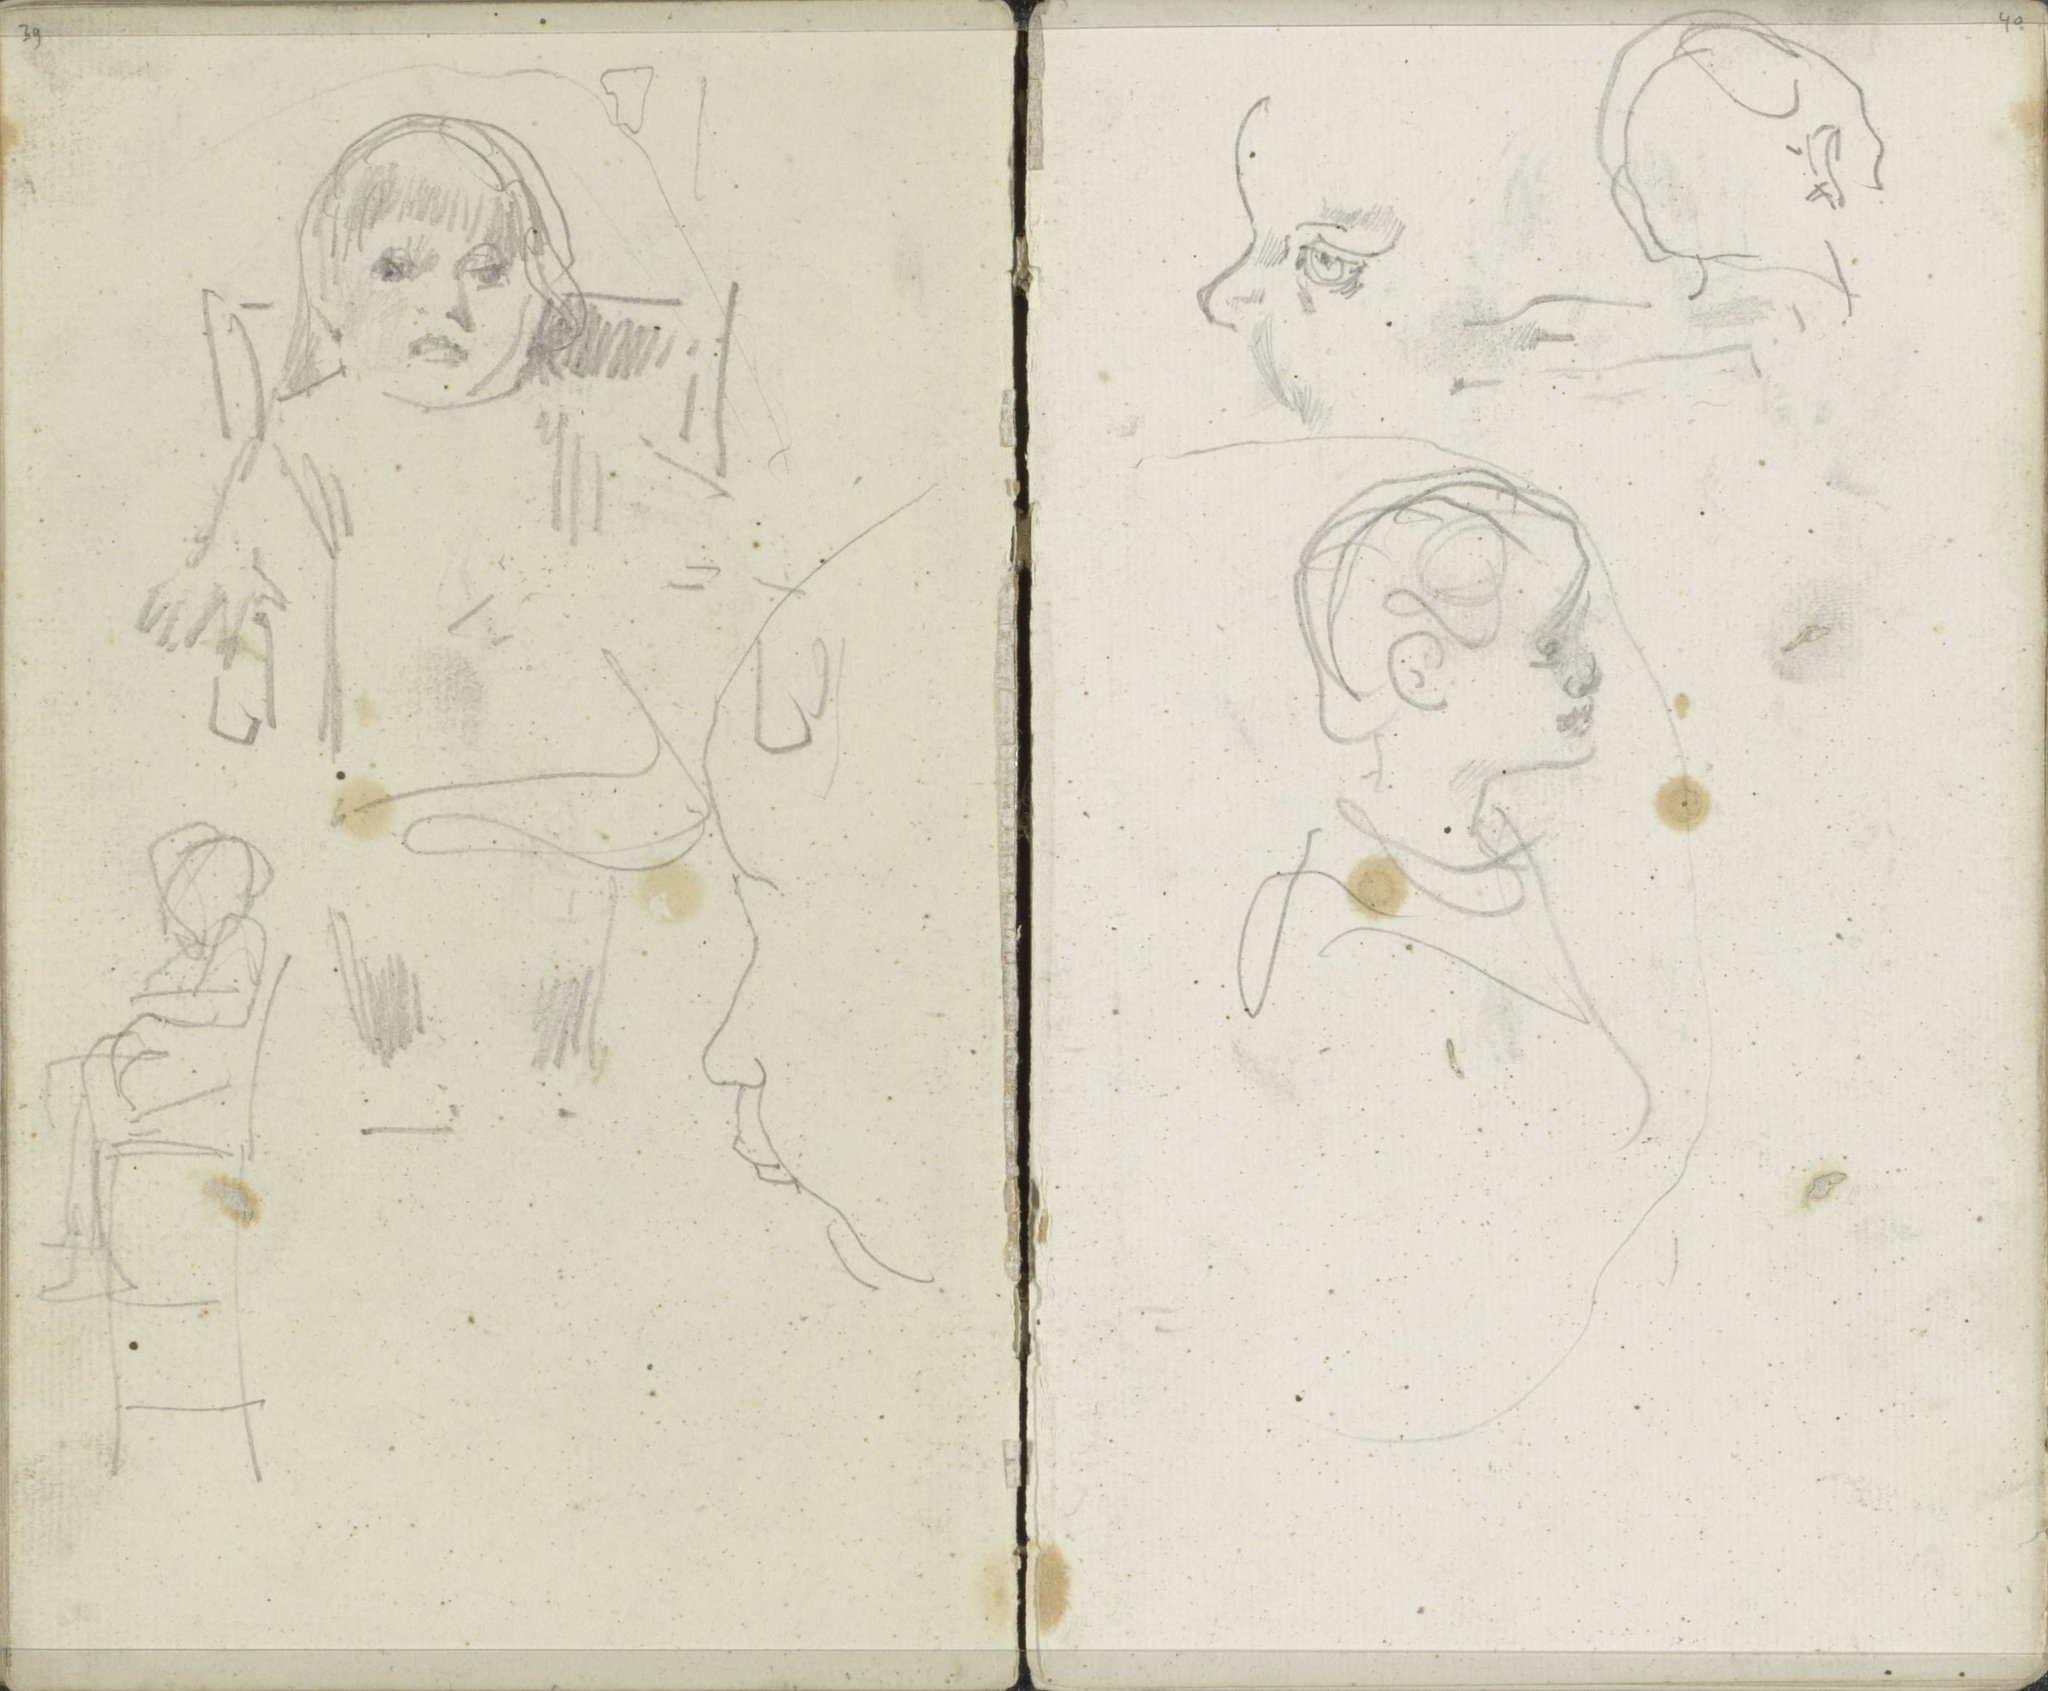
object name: sketchbook leaf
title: Studieblad met kinderen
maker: george hendrik breitner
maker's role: draughtsman, painter, print maker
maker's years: 1857-1923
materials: paper, pencil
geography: the hague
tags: child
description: Links twee studies van een kind op een kinderstoel. Pagina 39 en pagina 40 uit een schetsboek met 28 bladen.